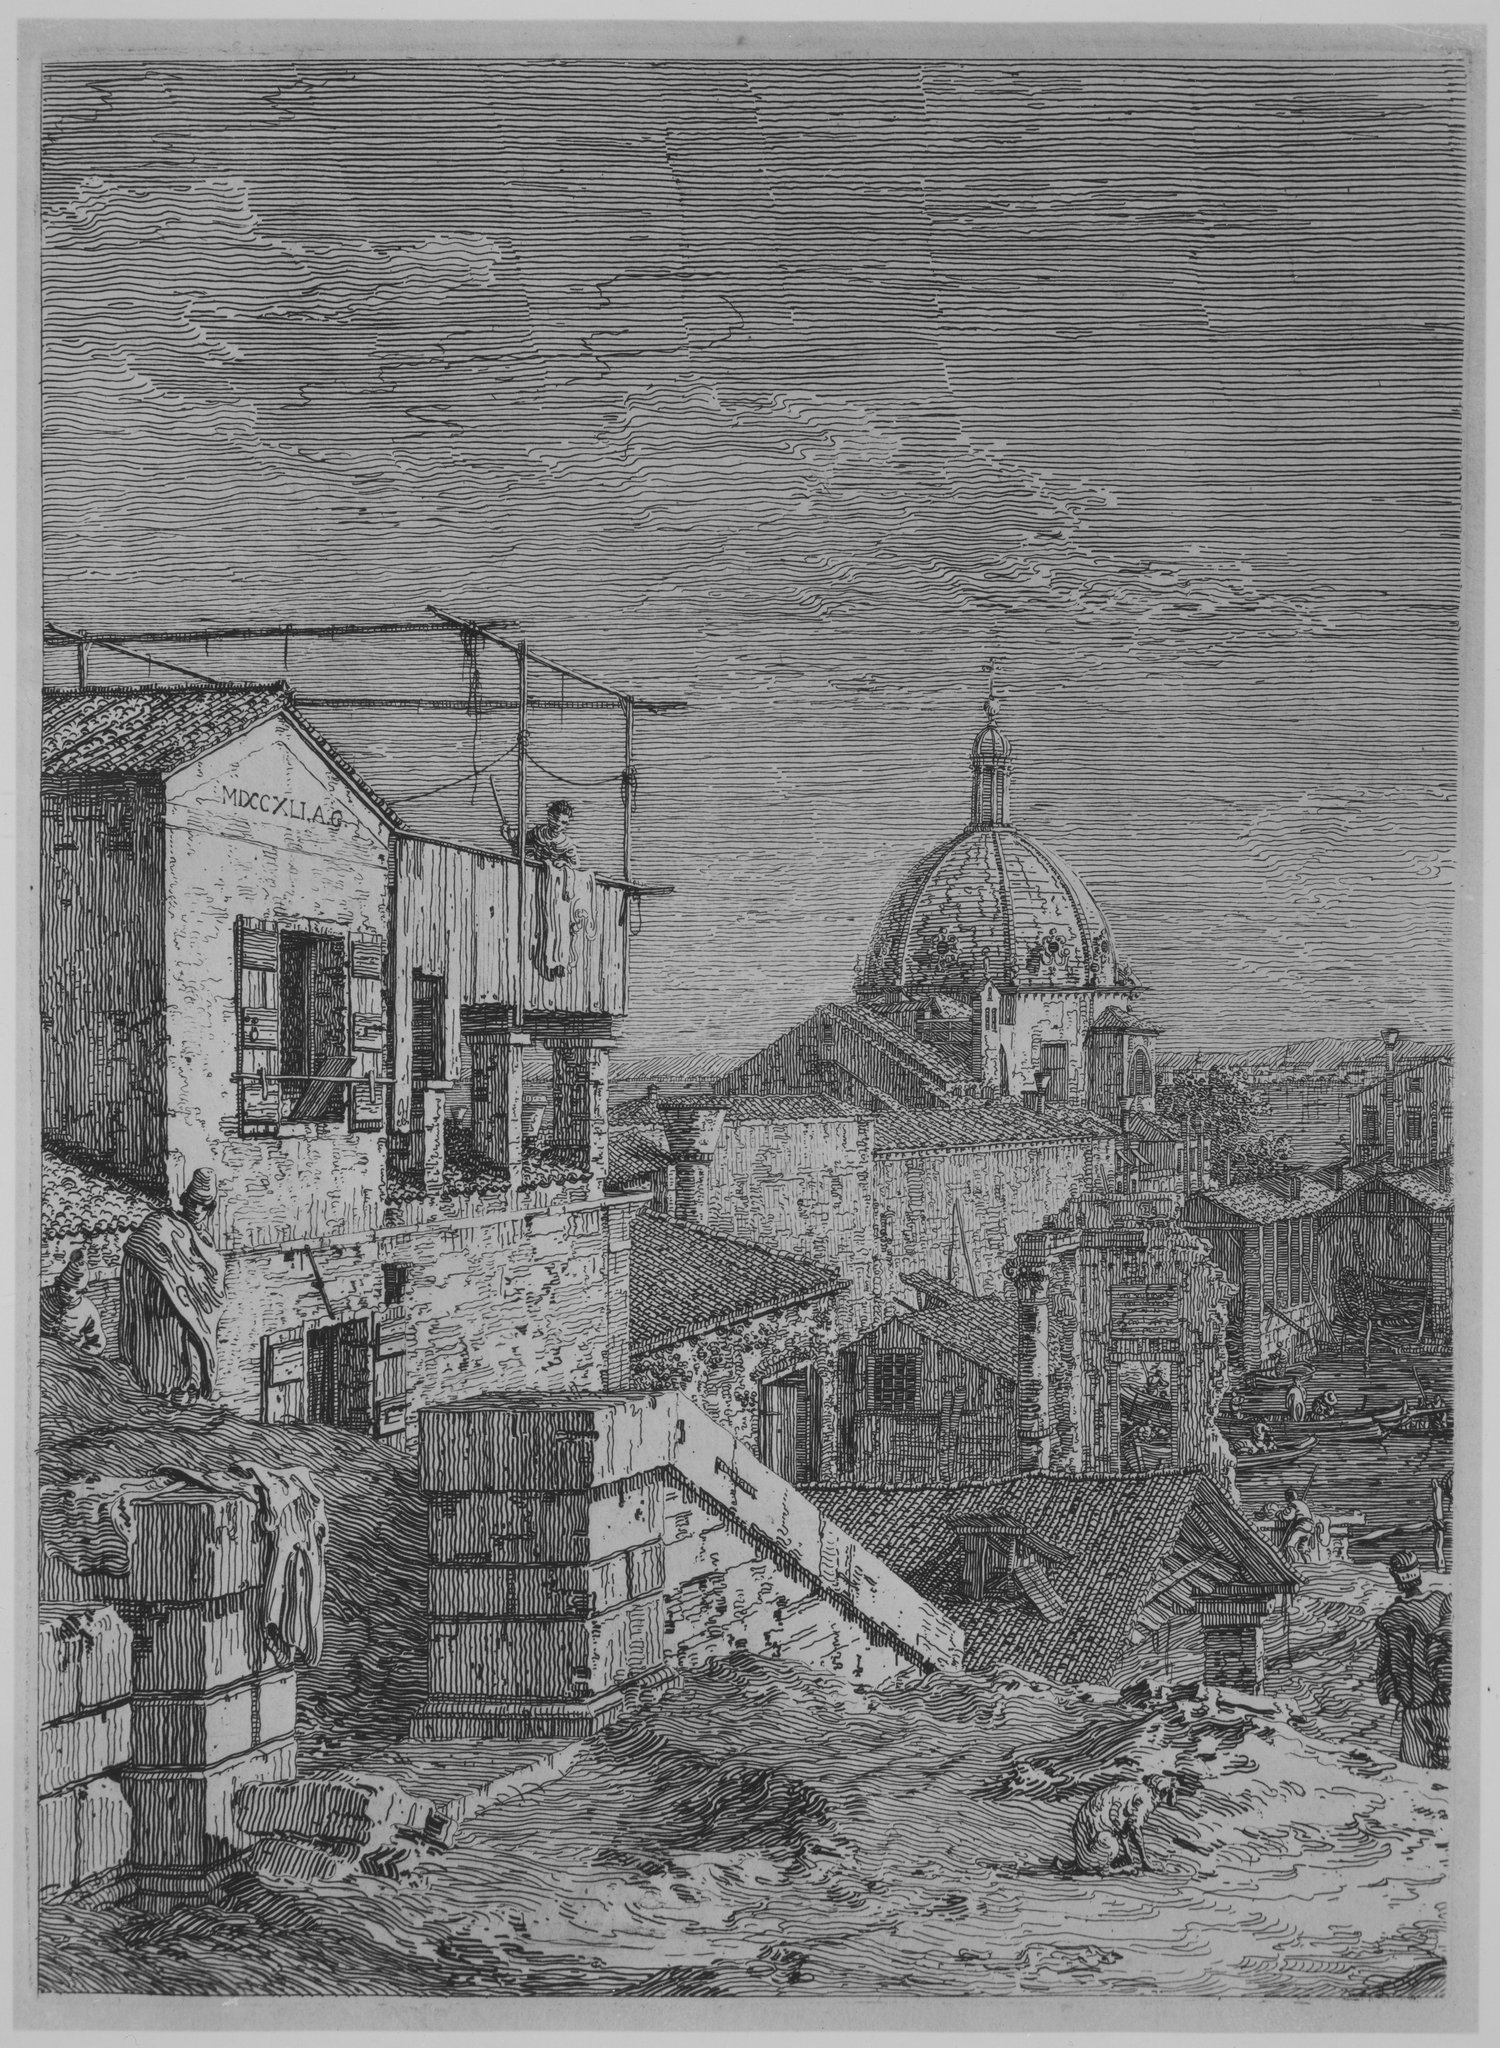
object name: book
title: Vedute altre prese da i luoghi altre ideate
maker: canaletto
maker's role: artist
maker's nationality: italian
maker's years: 1697-1768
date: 1701-1800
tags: buildings